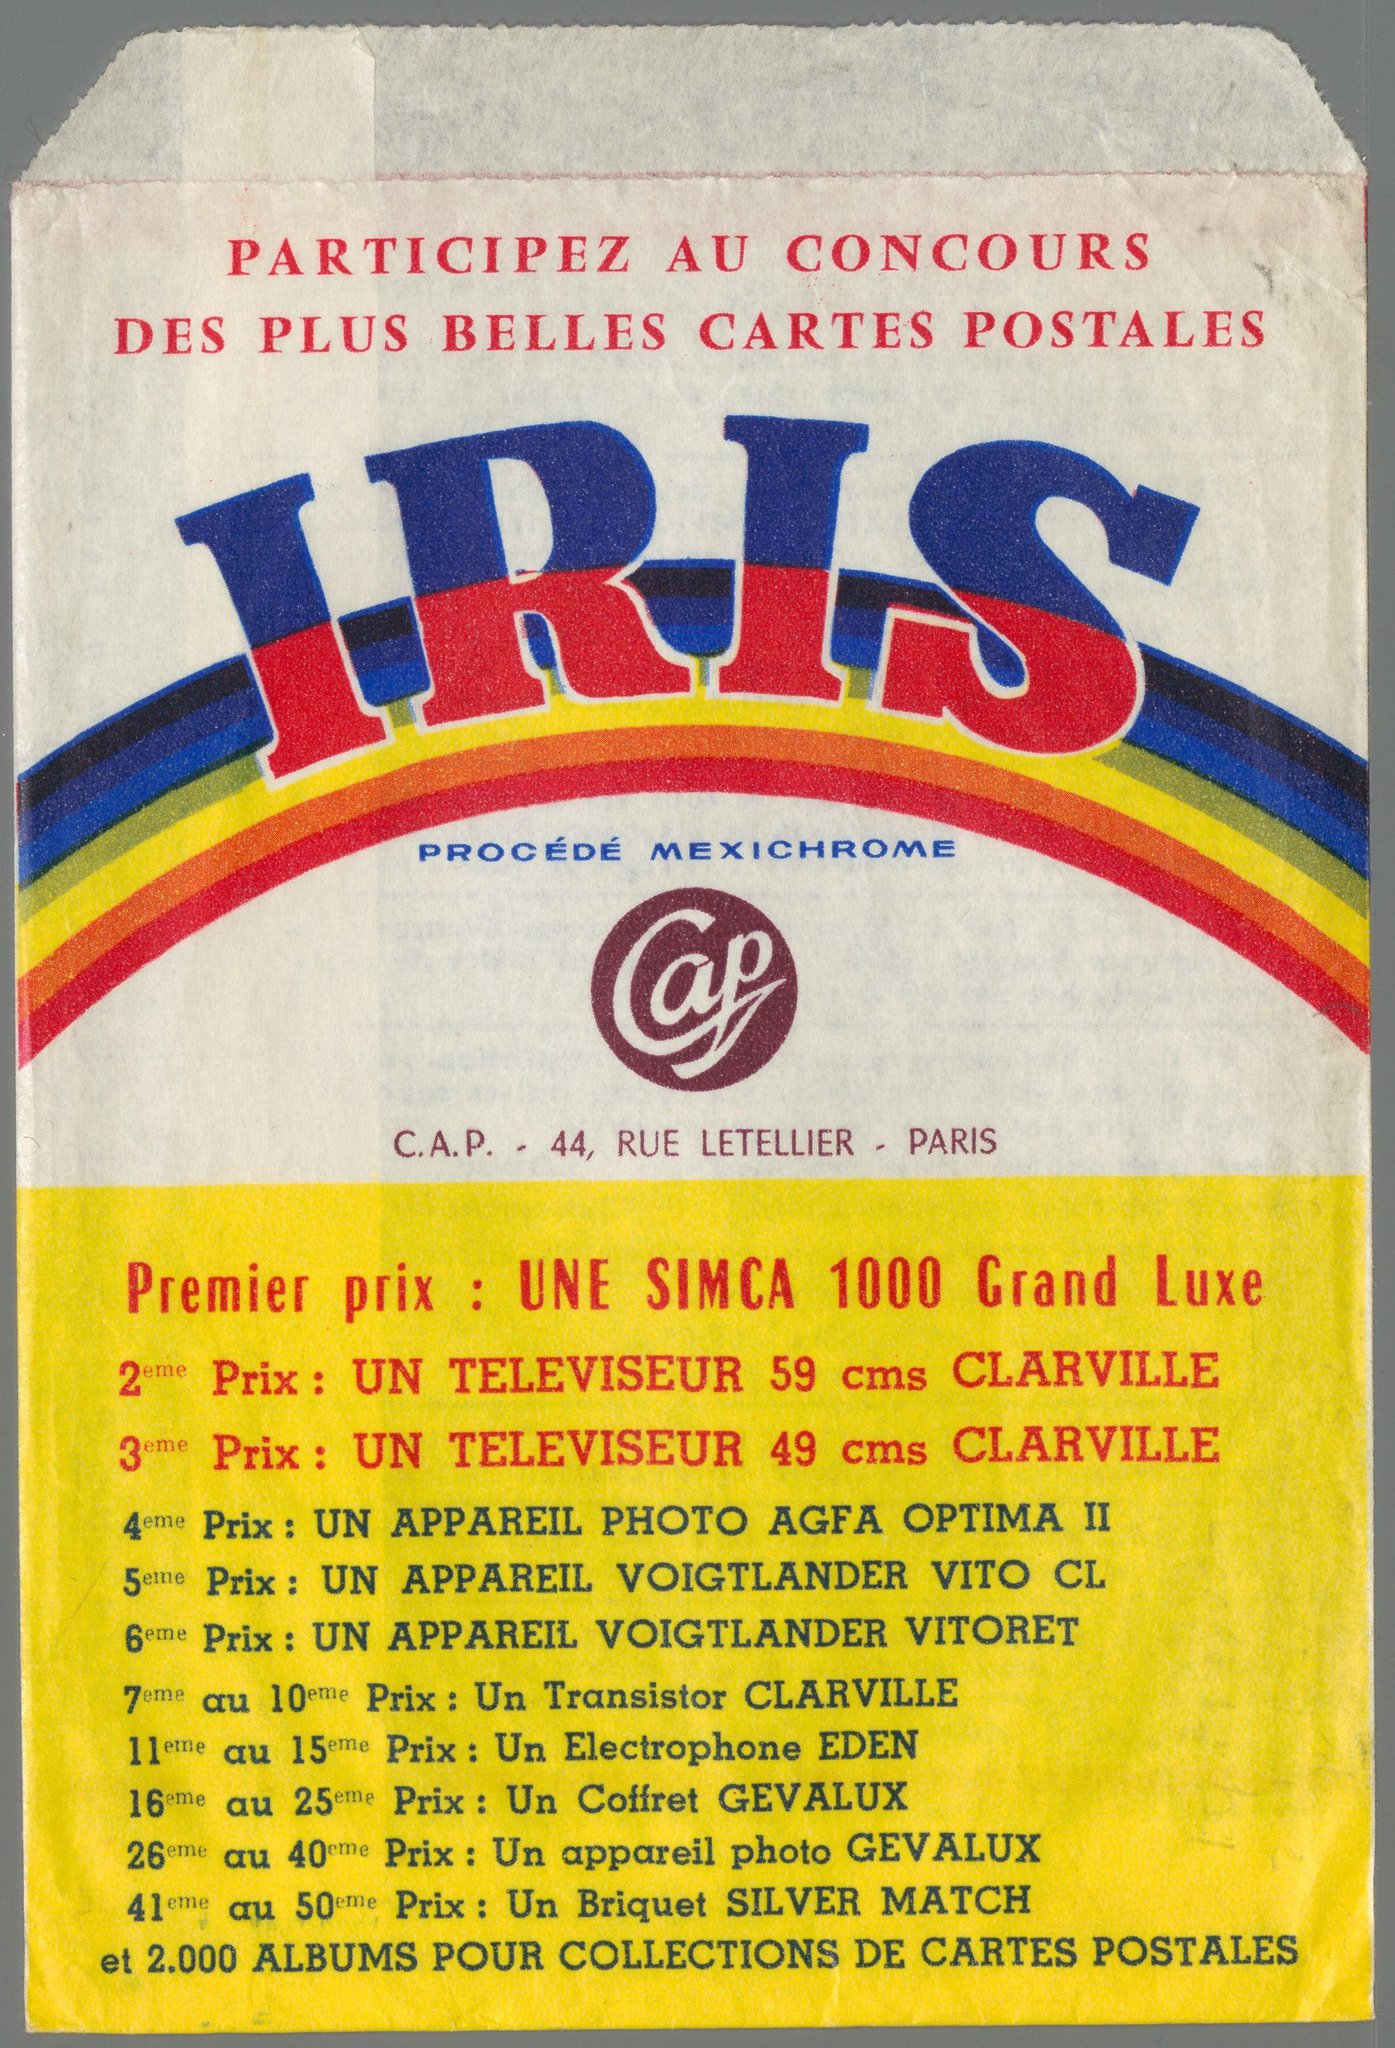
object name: envelope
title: Participez au concours des plus belles cartes postales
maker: Anonymous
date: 1950-1970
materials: paper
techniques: folding, offset printed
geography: paris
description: Omslag voor prentbriefkaarten met daarop de uitnodiging mee te doen aan een wedstrijd om de mooiste prentbriefkaarten te kiezen. Op recto staat vermeld dat er een auto, televisies en diverse typen camera's zijn te winnen. Op verso staat het reglement van de wedstrijd.